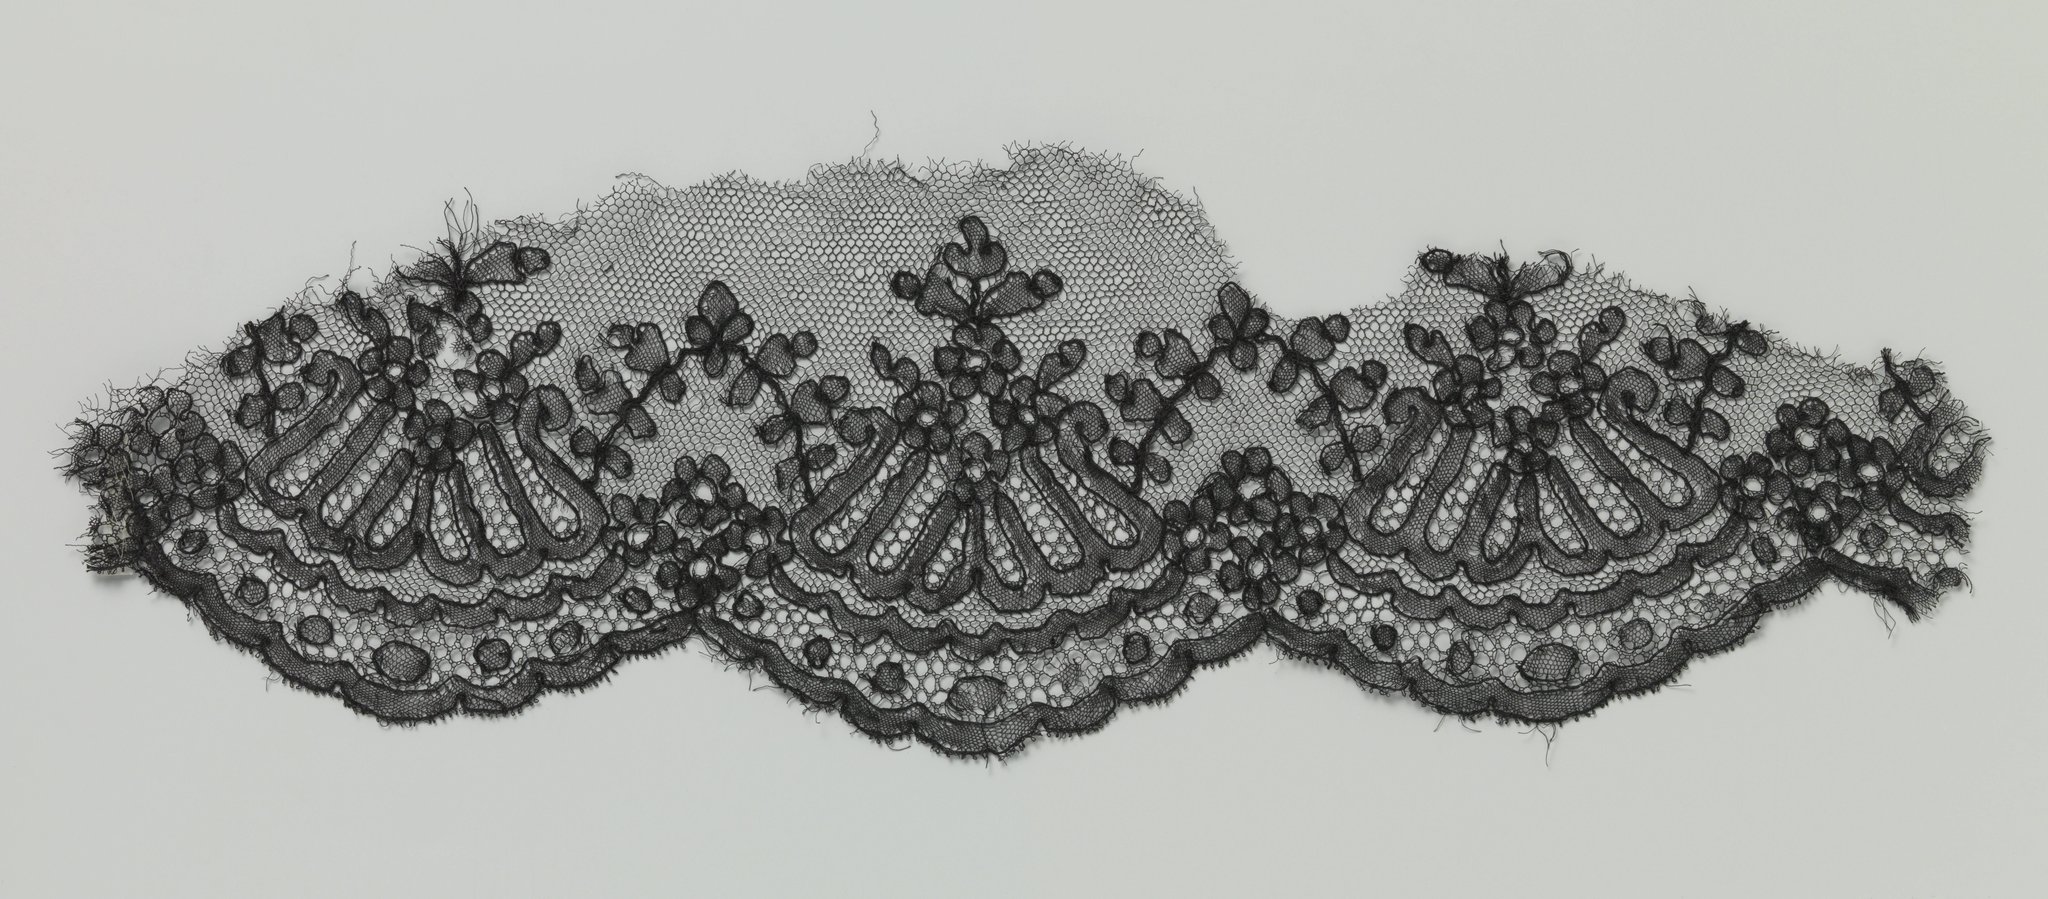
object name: fragment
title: Fragment kloskant met omgekeerde waaiervormig motief in schulpenrand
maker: Anonymous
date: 1850-1899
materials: silk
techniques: lace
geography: belgium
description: Fragment zwarte kloskant: Chantilly-kant. Het fragment is langwerpig van vorm, met aan één lange zijde een schulpenrand, de andere zijden zijn onregelmatig afgeknipt. Het zich herhalende patroon bestaat uit een ruitvormige configuratie van vier rozetbloemen, waaronder een min of meer waaiervormig motief hangt. De opeenvolgende waaiers zijn door boogjes met blaadjes verbonden. Onder elk boogje staan weer vier rozetbloempjes, die de ophangpunten van de doorlopende sierband vormen die tevens de schulpenrand vormt. De sierband bestaat uit twee slingers waartussen losse ronde motiefjes staan. De motieven zijn gemaakt in netslag met contourdraden. Ze zijn met elkaar verbonden door een fijne maasgrond, een tulegrond. Als siergrond is een rozengrond toegepast. De schulpenrand is afgewerkt met picots.